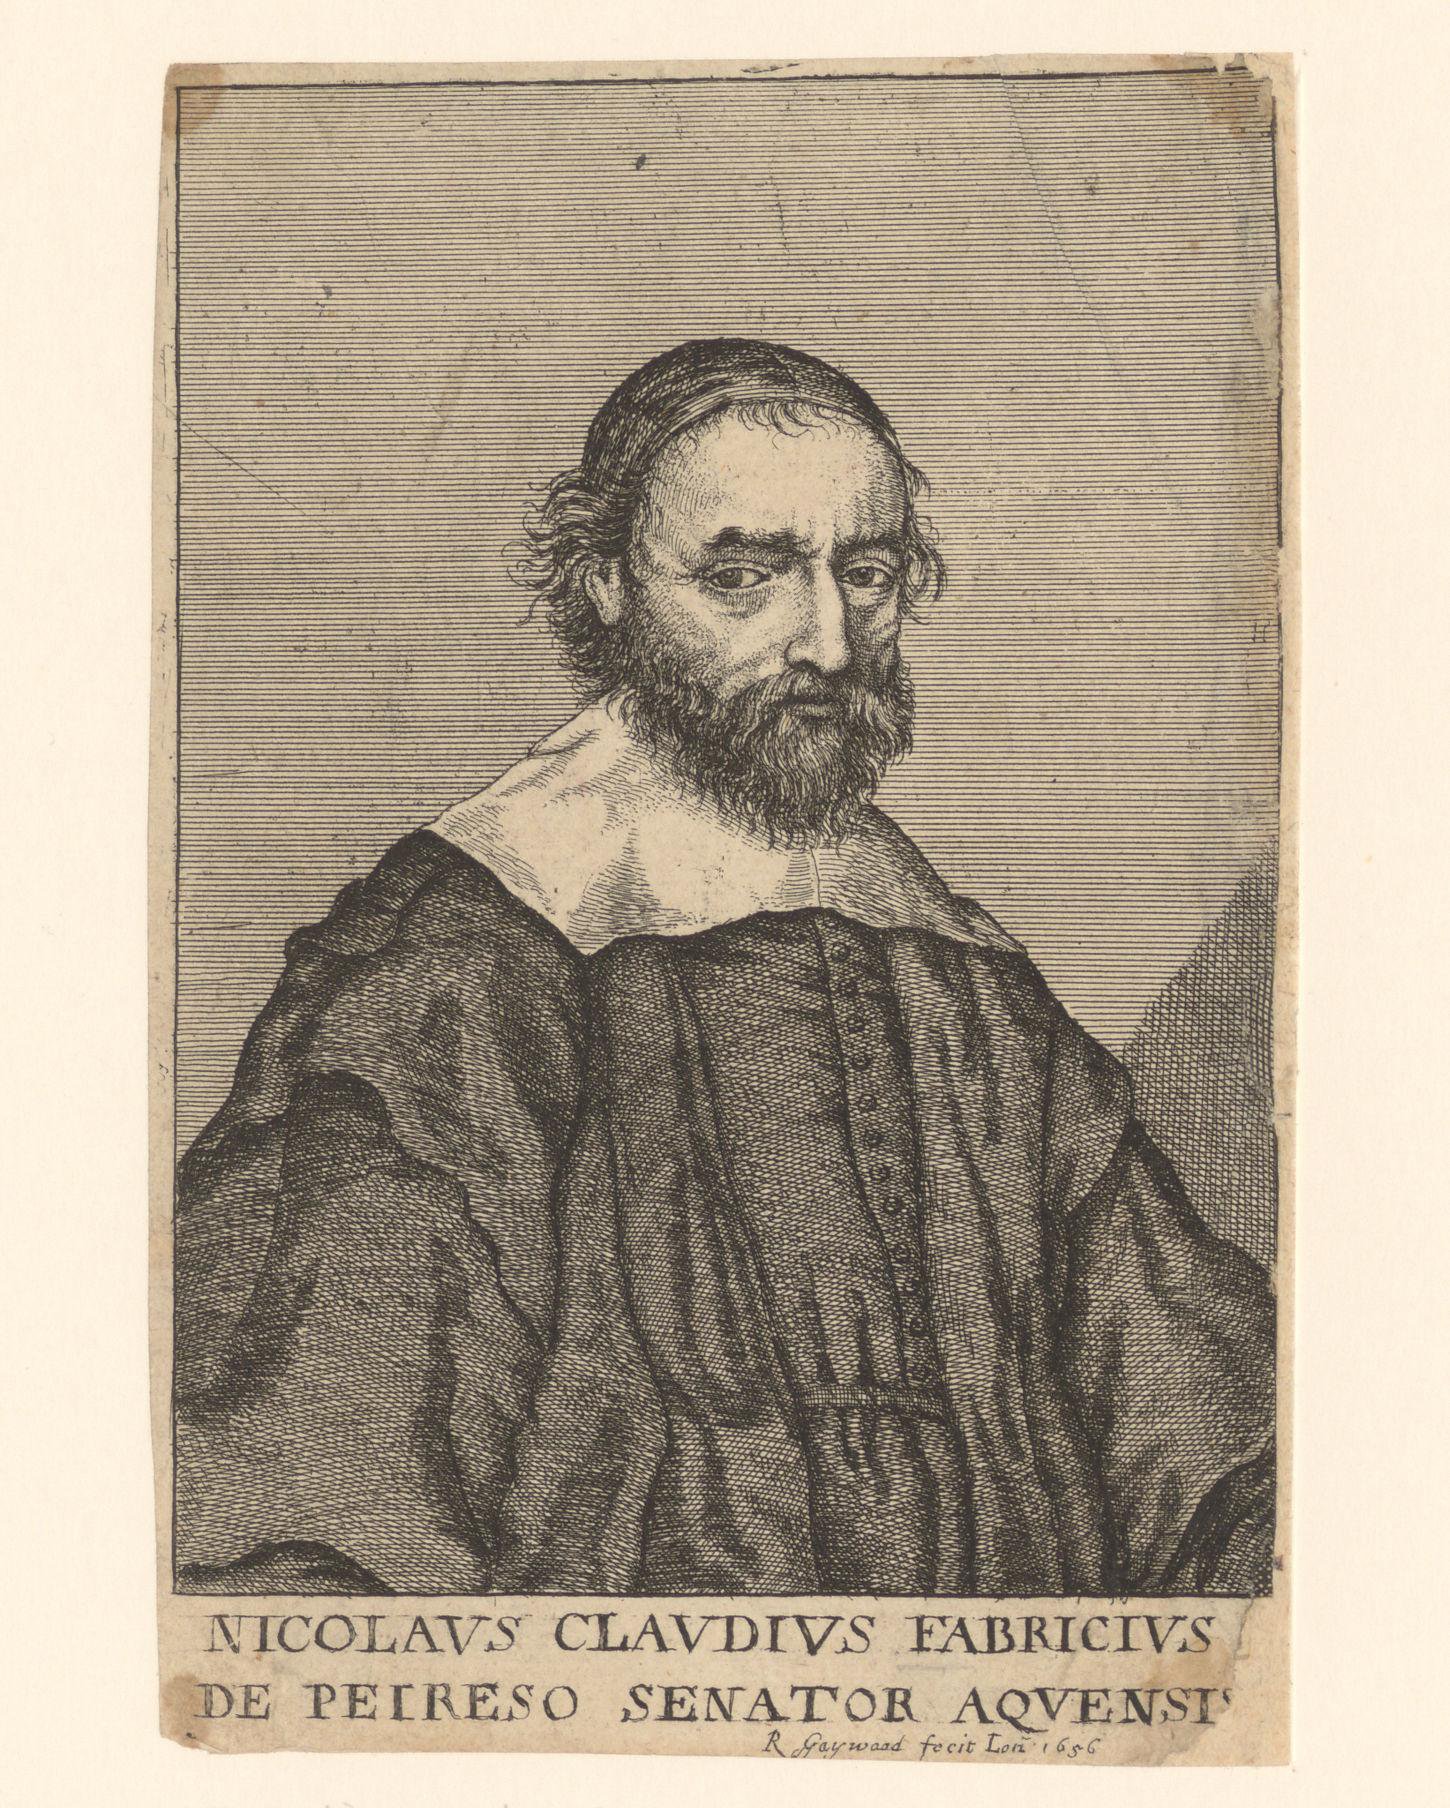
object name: print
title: Portret van Nicolas-Claude Fabri de Peiresc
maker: robert gaywood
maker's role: print maker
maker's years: 1650-1711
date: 1656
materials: paper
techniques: etching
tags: astronomy (and cosmography) (+ portrait of scholar, scientist), historical persons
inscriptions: collector's mark: Lugt 2228